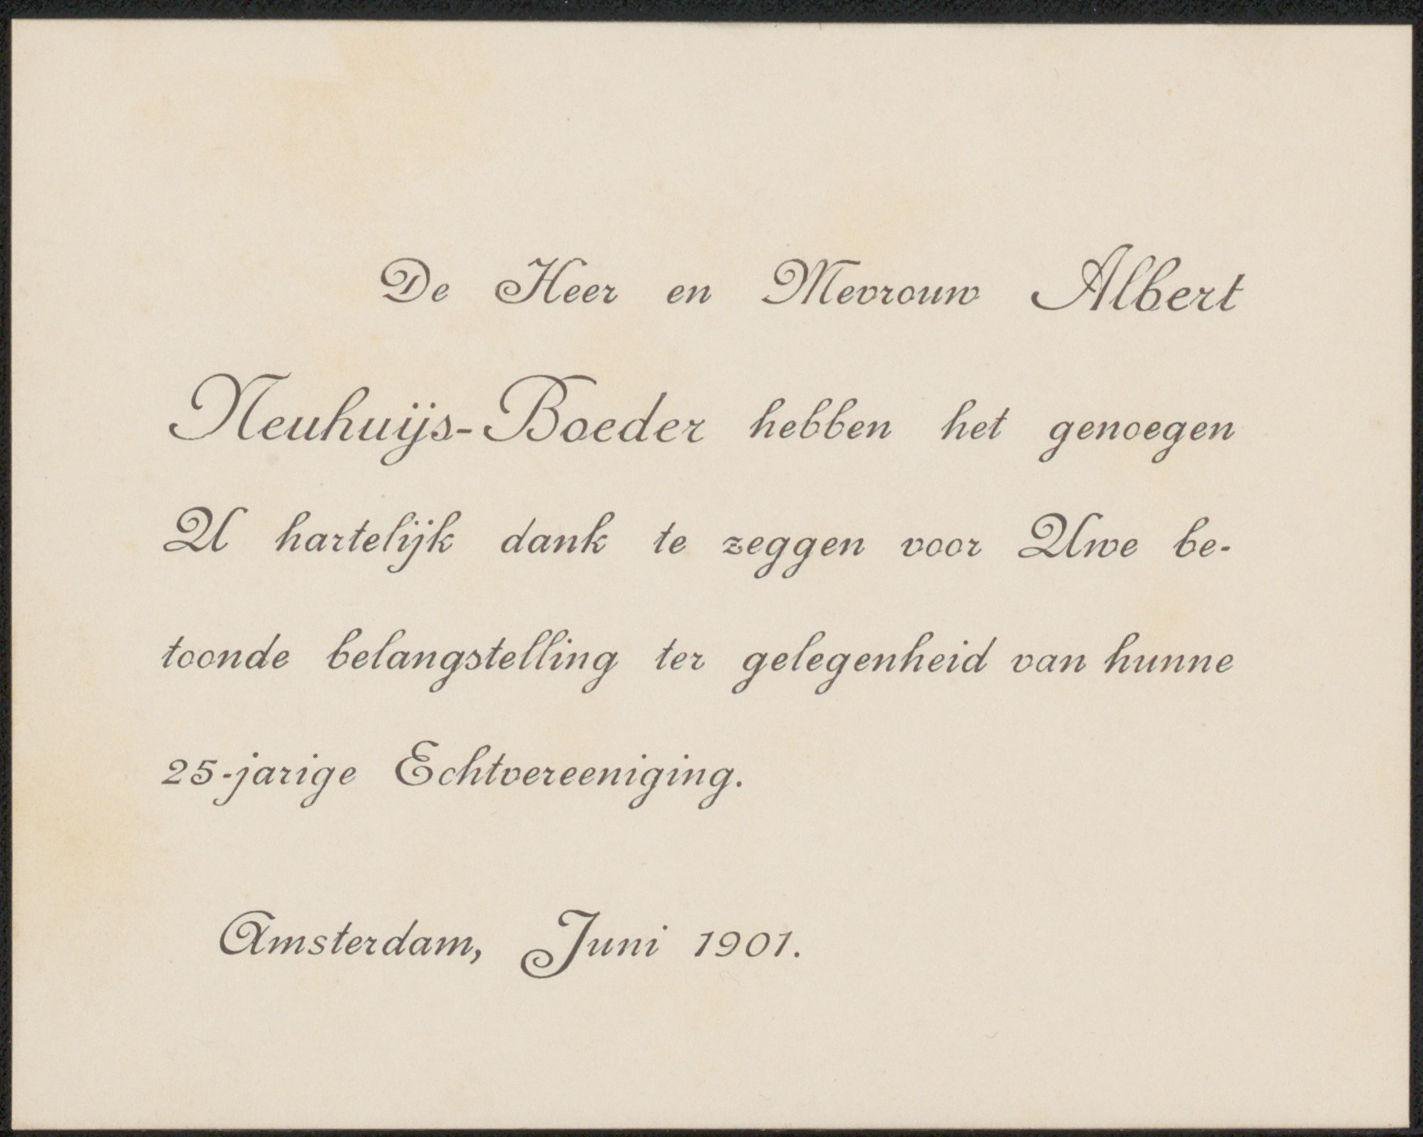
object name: bedankkaart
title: Bedankkaart aan Philip Zilcken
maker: Anonymous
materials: cardboard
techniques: printing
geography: amsterdam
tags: utrecht, print maker, albert neuhuys (1844-1914), the hague, painter, draughtsman, philip zilcken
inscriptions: collector's mark: ‘RPK’